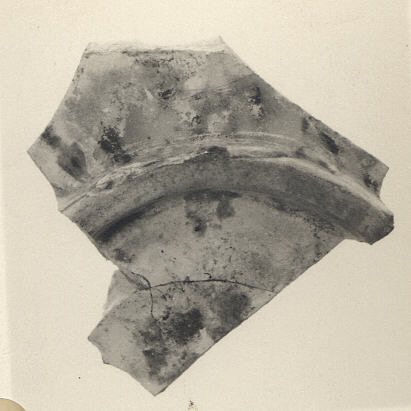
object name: fragment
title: Fragment of a Bowl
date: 801-1000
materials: porcelain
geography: china